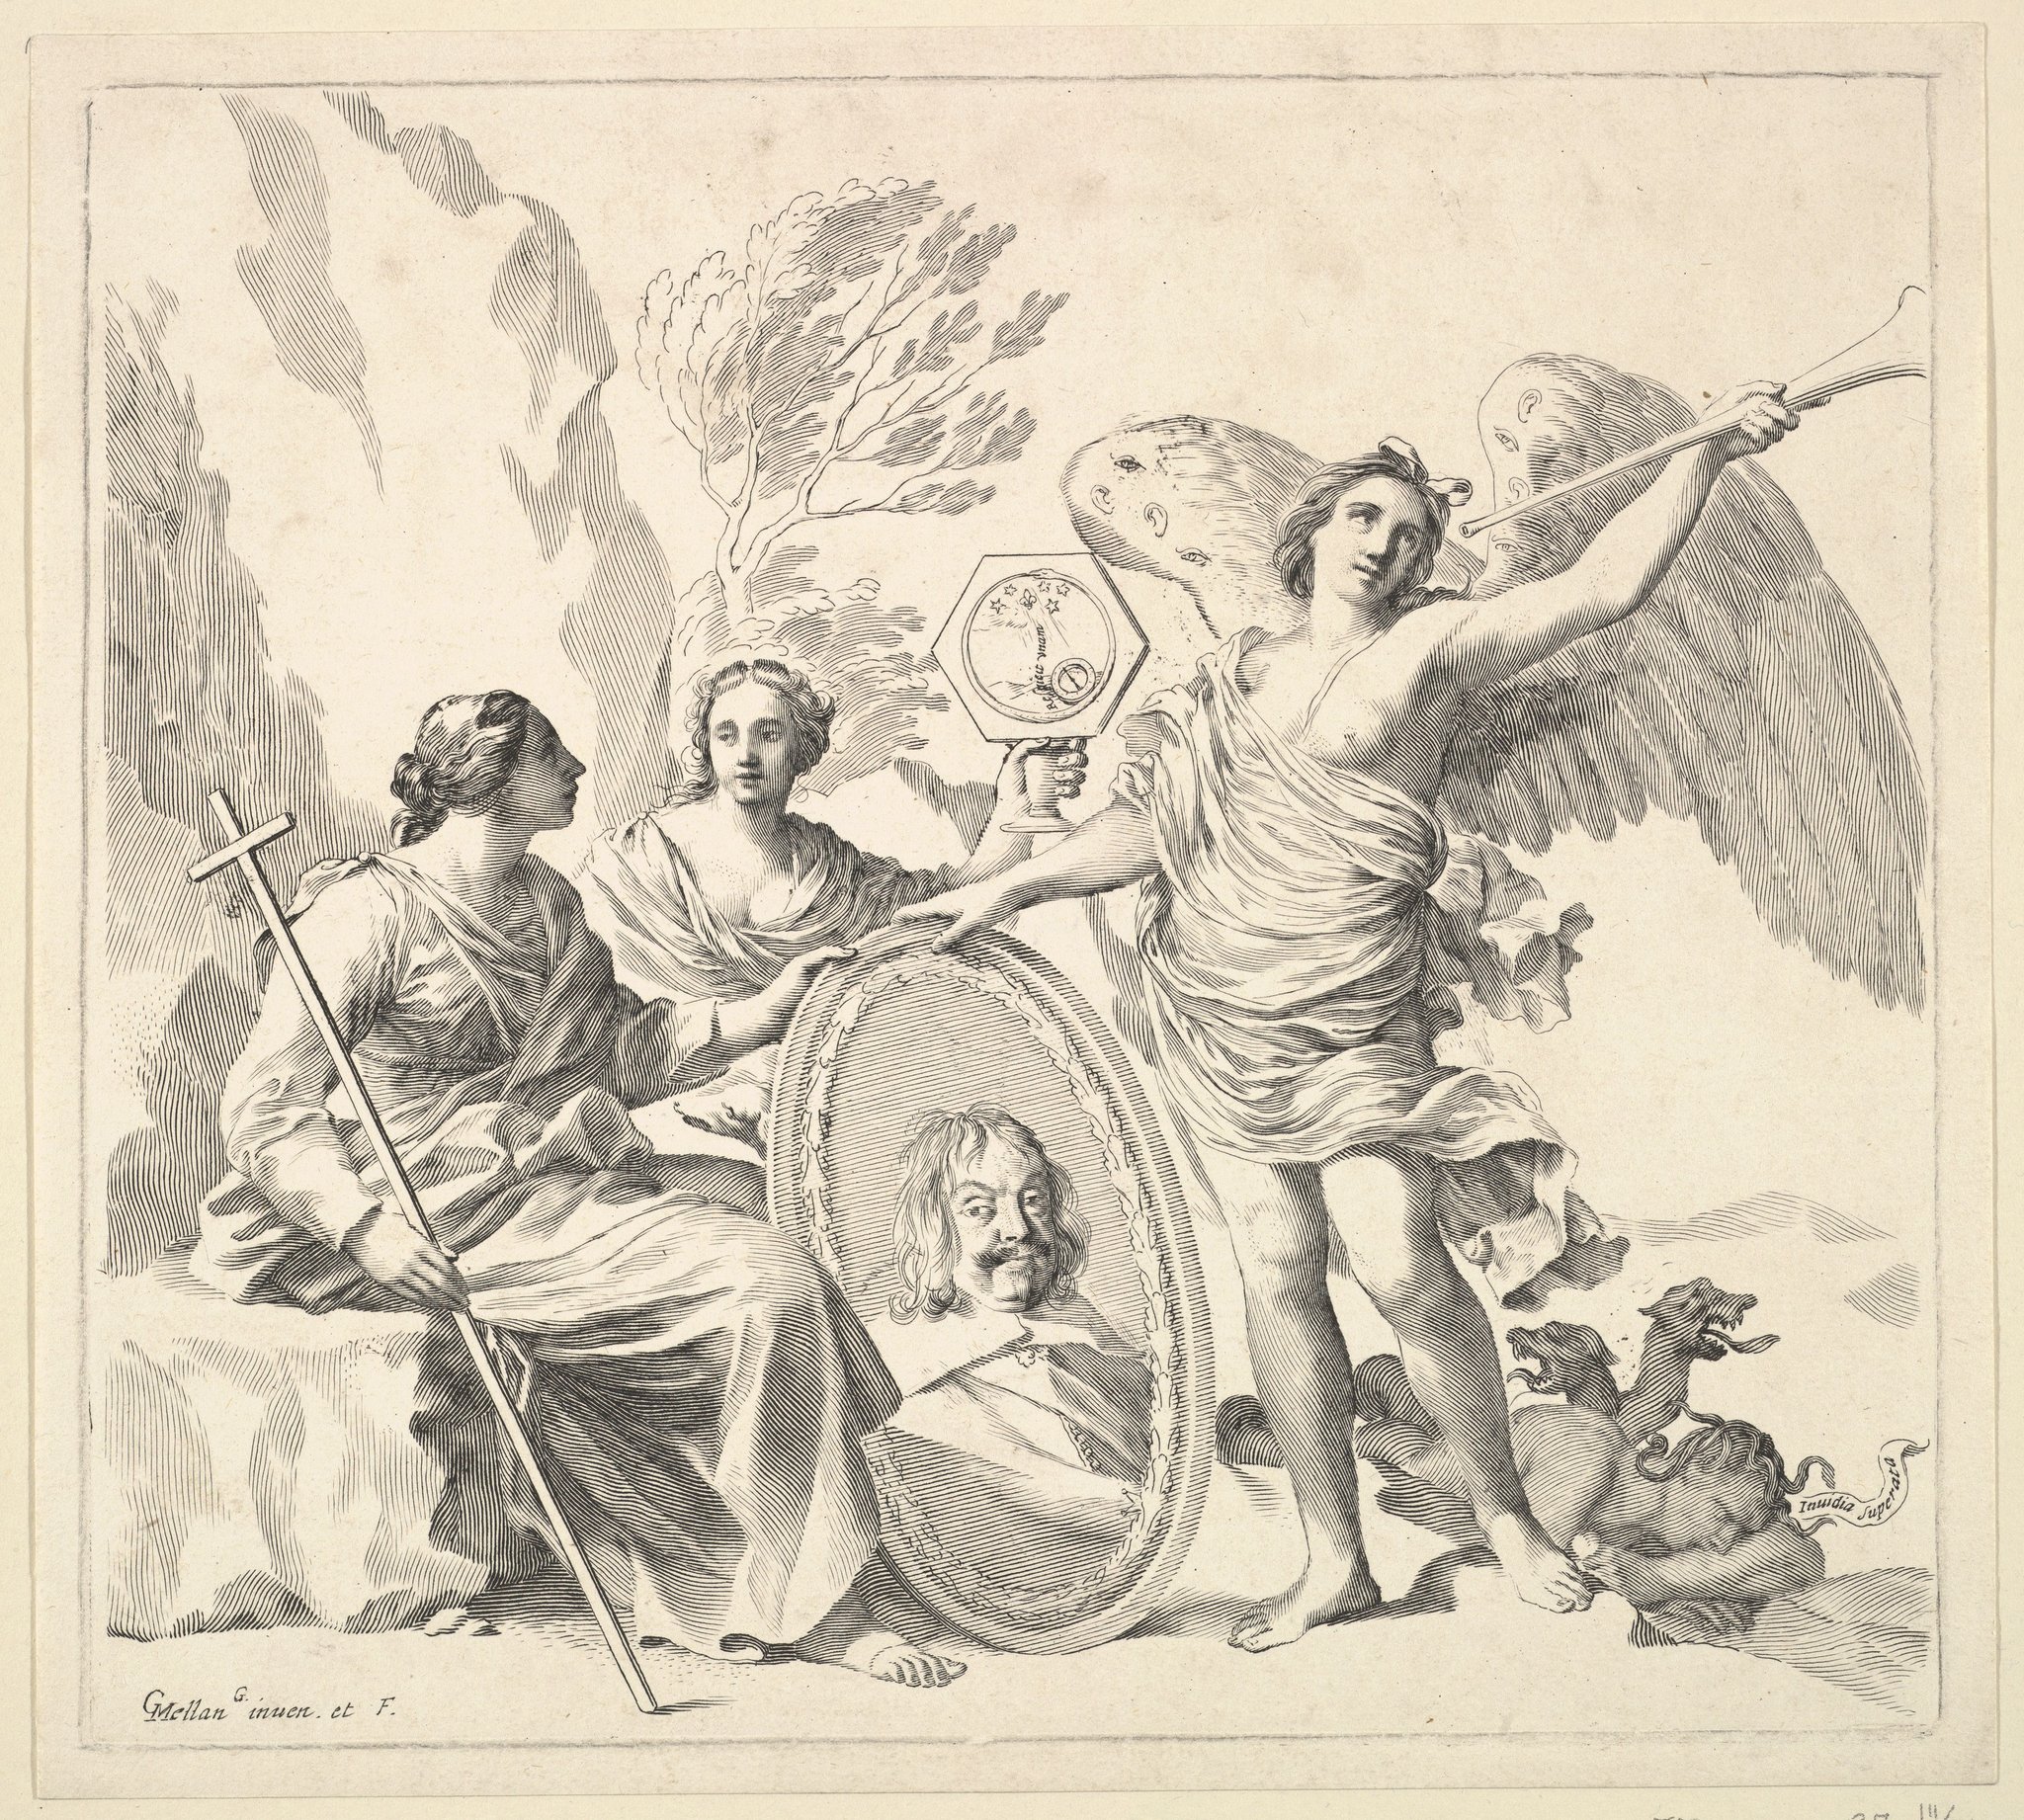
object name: print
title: Louis-Emmanuel de Valois, comte d'Alais et duc d'Angoulême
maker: claude mellan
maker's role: artist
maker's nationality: french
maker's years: 1598-1688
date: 1601-1700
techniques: engraving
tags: men,portraits,women,angels